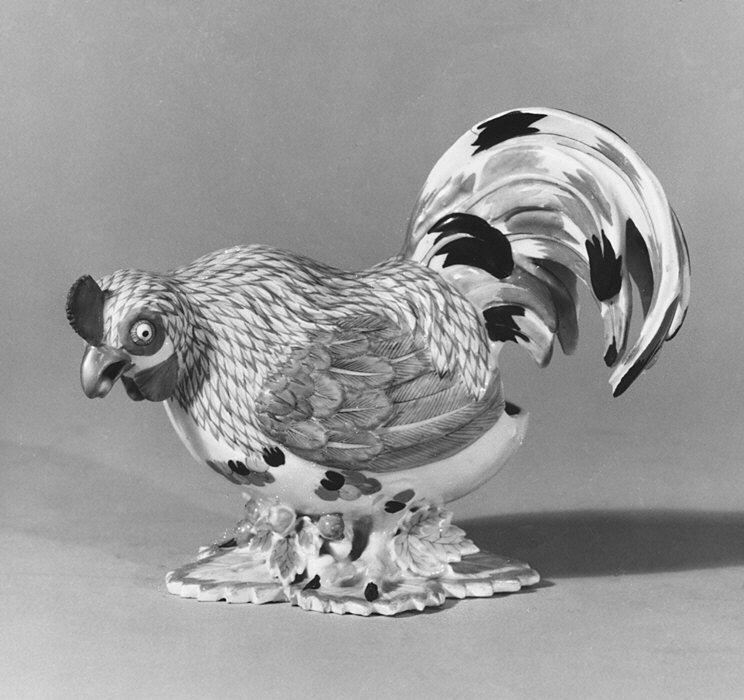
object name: figure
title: Chinese rooster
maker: meissen manufactory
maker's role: manufactory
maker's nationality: german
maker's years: 1710-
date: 1732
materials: hard paste porcelain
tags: roosters